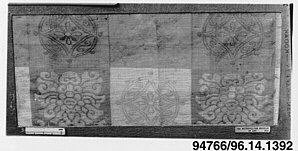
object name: textile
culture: japanese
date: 1701-1900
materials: silk